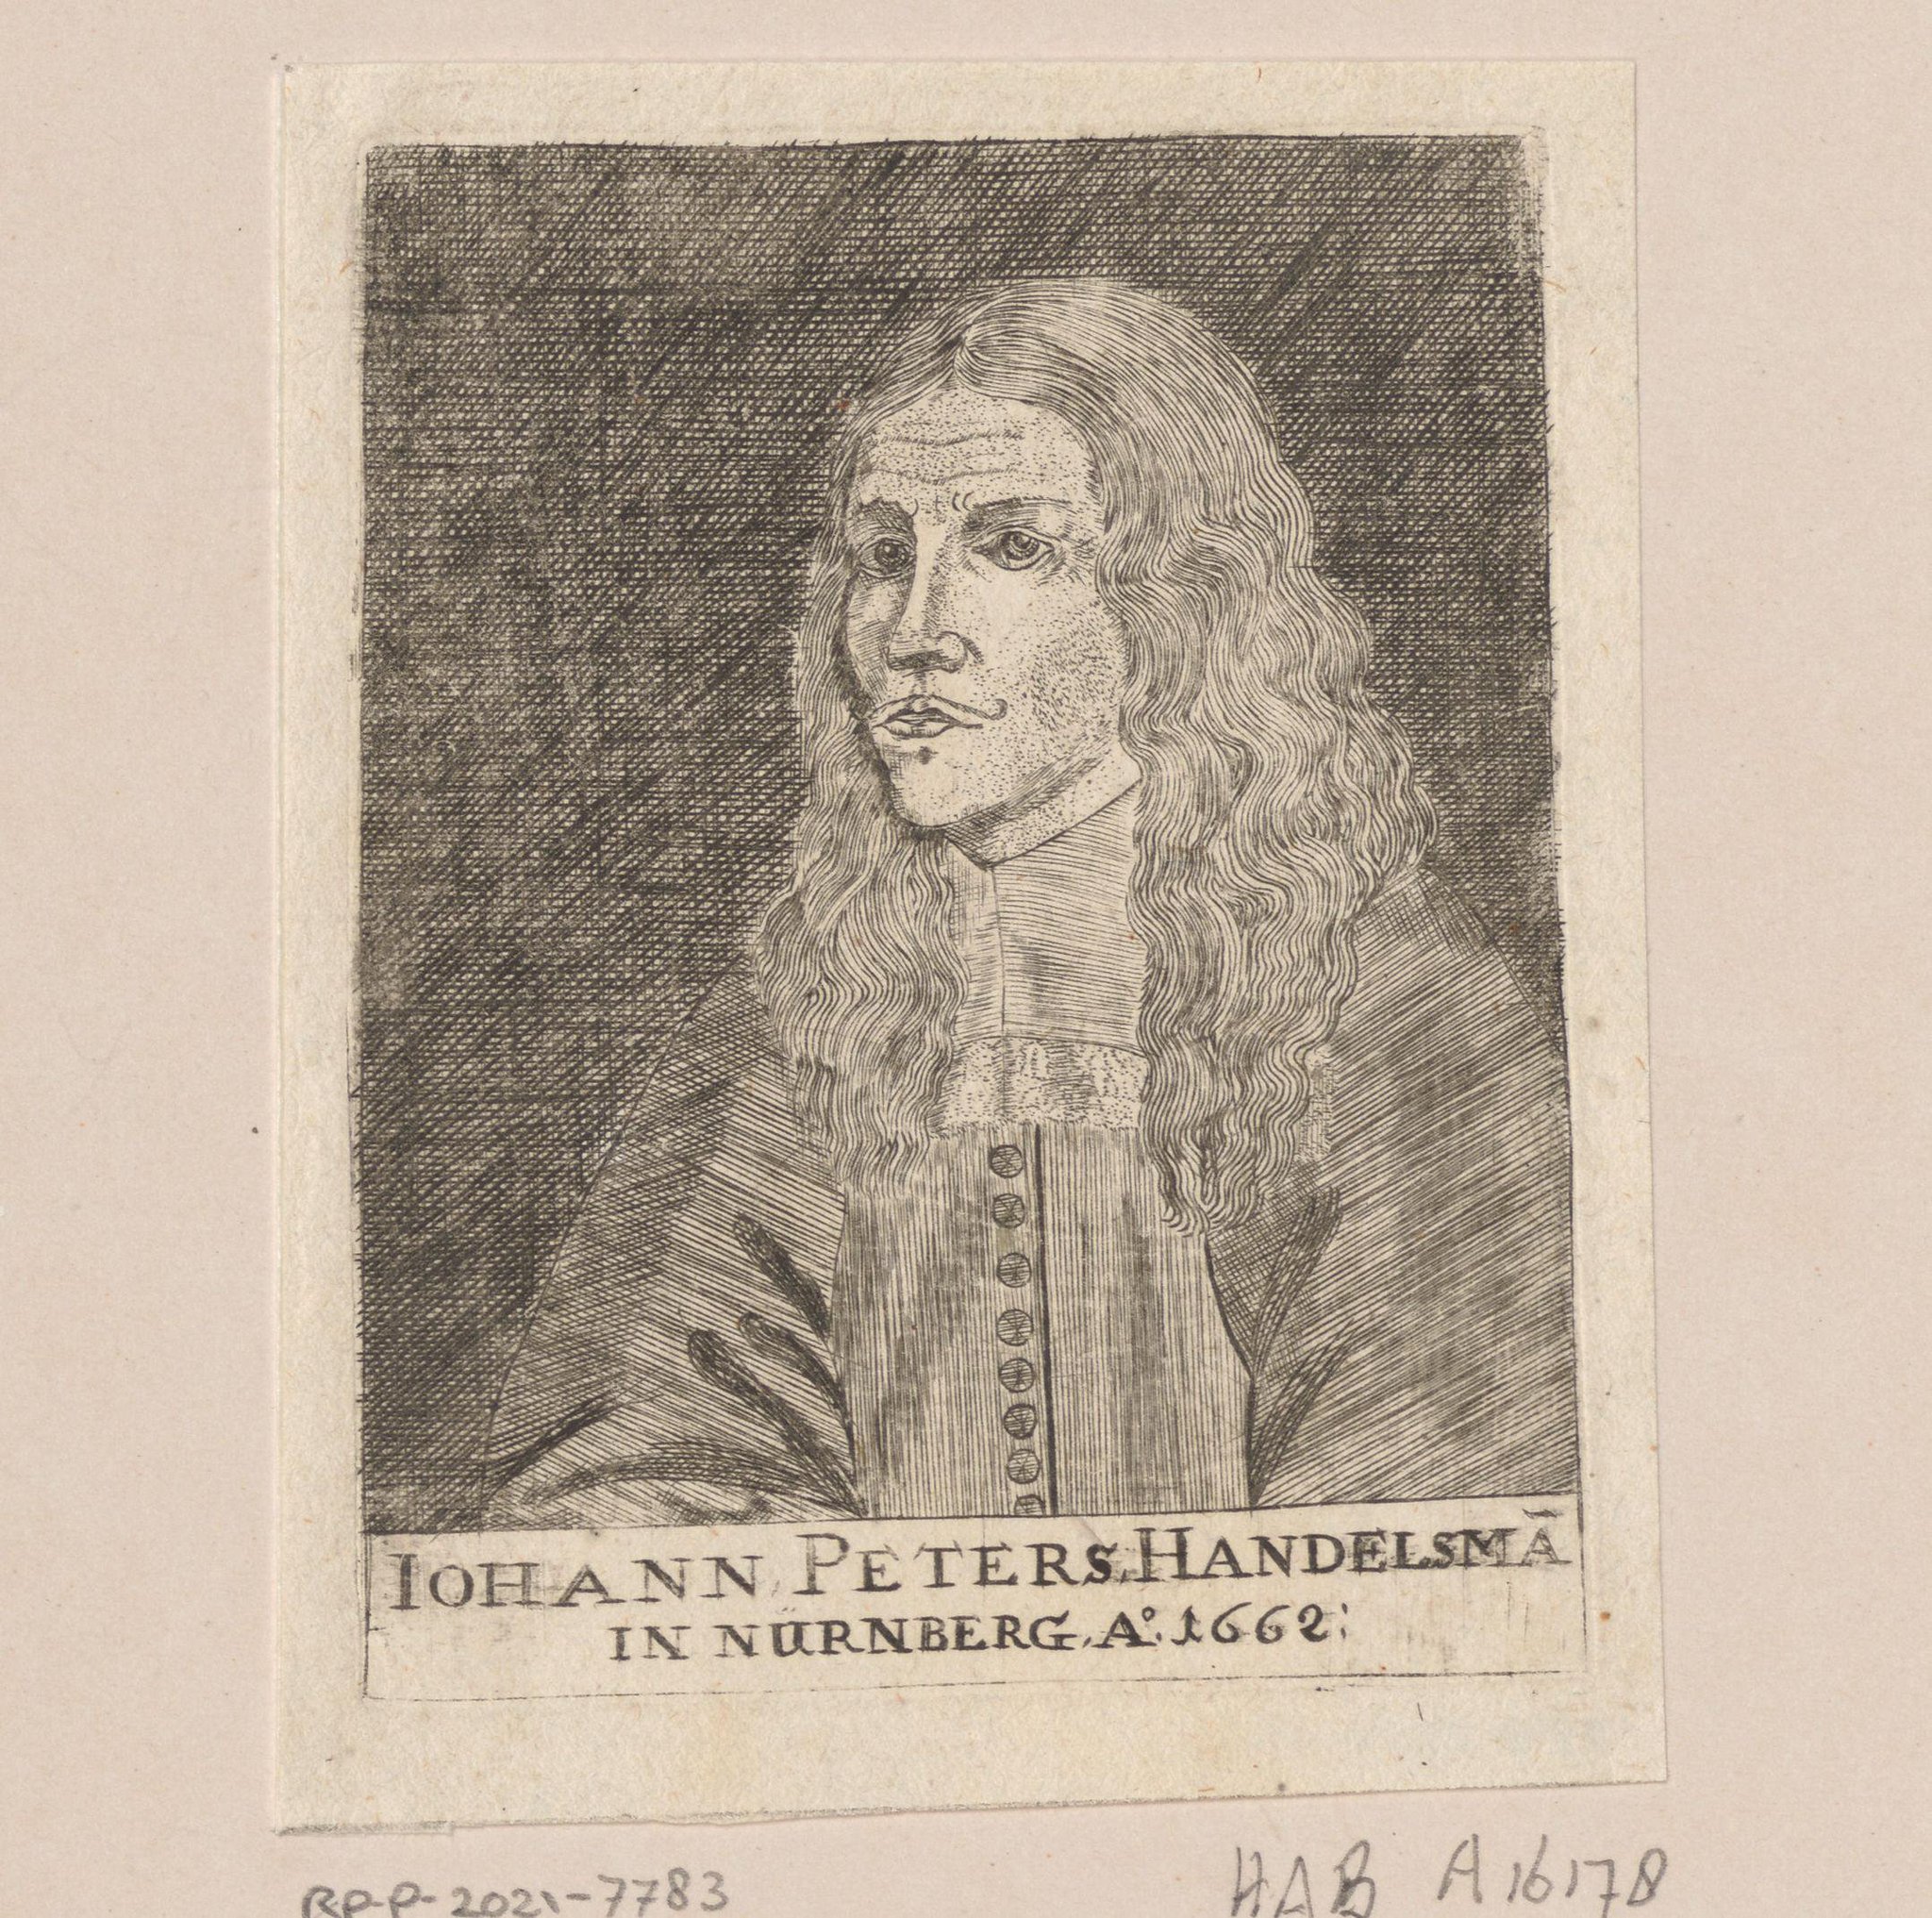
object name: print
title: Portret van Johann Peters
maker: Anonymous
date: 1662-1699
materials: paper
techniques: engraving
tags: adult man, historical persons